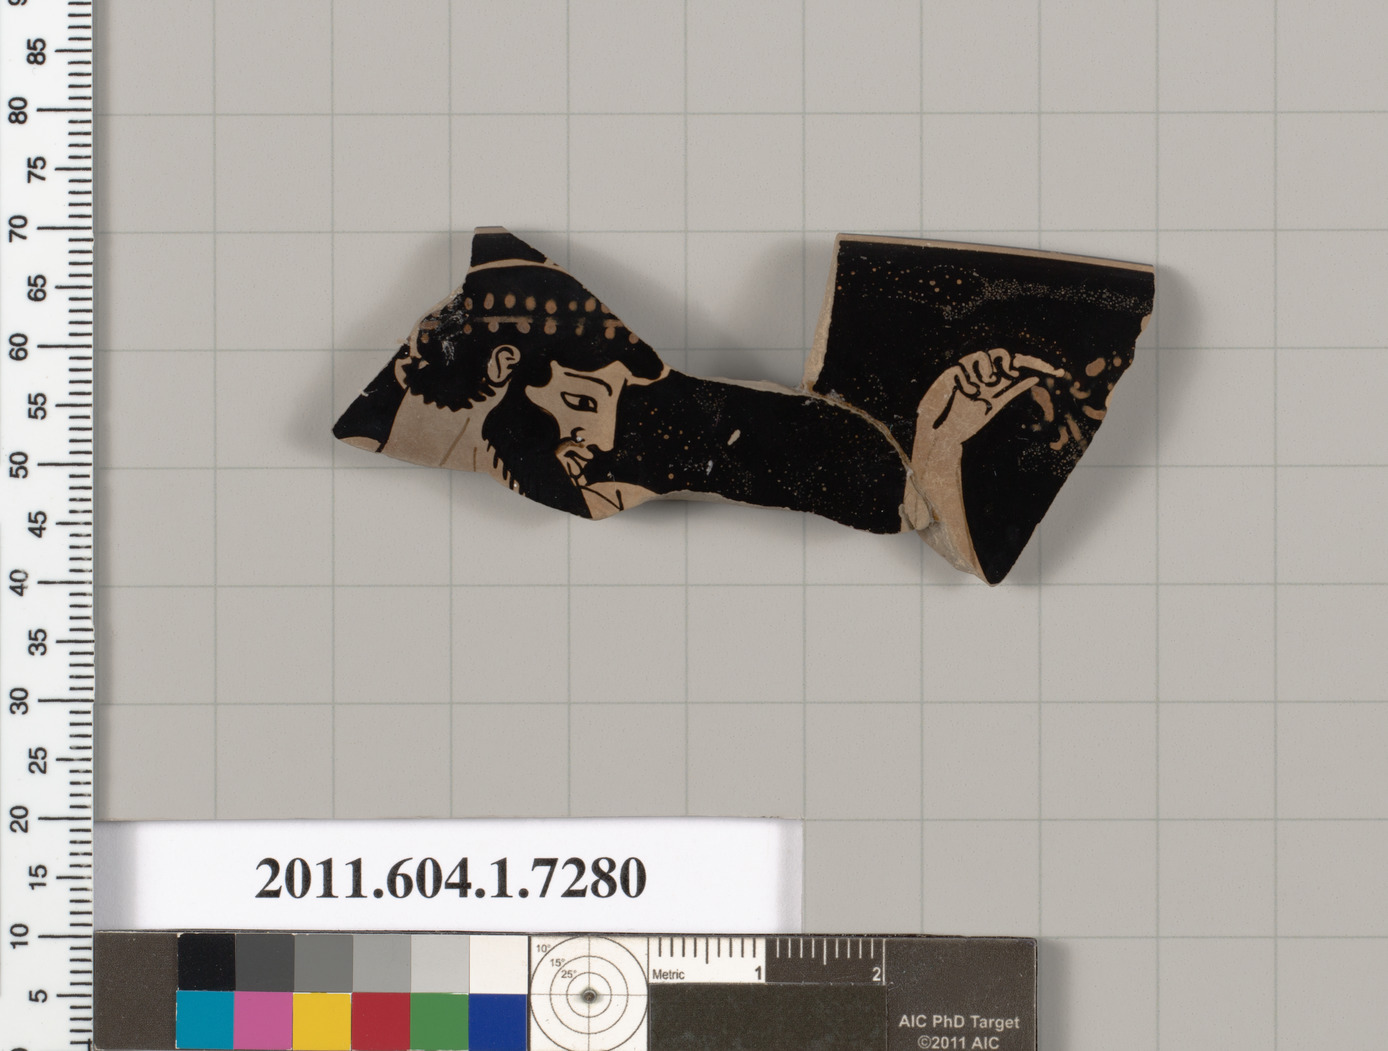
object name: kylix fragment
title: Terracotta rim fragment of a kylix (drinking cup)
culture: greek, attic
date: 500-480 BCE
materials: terracotta